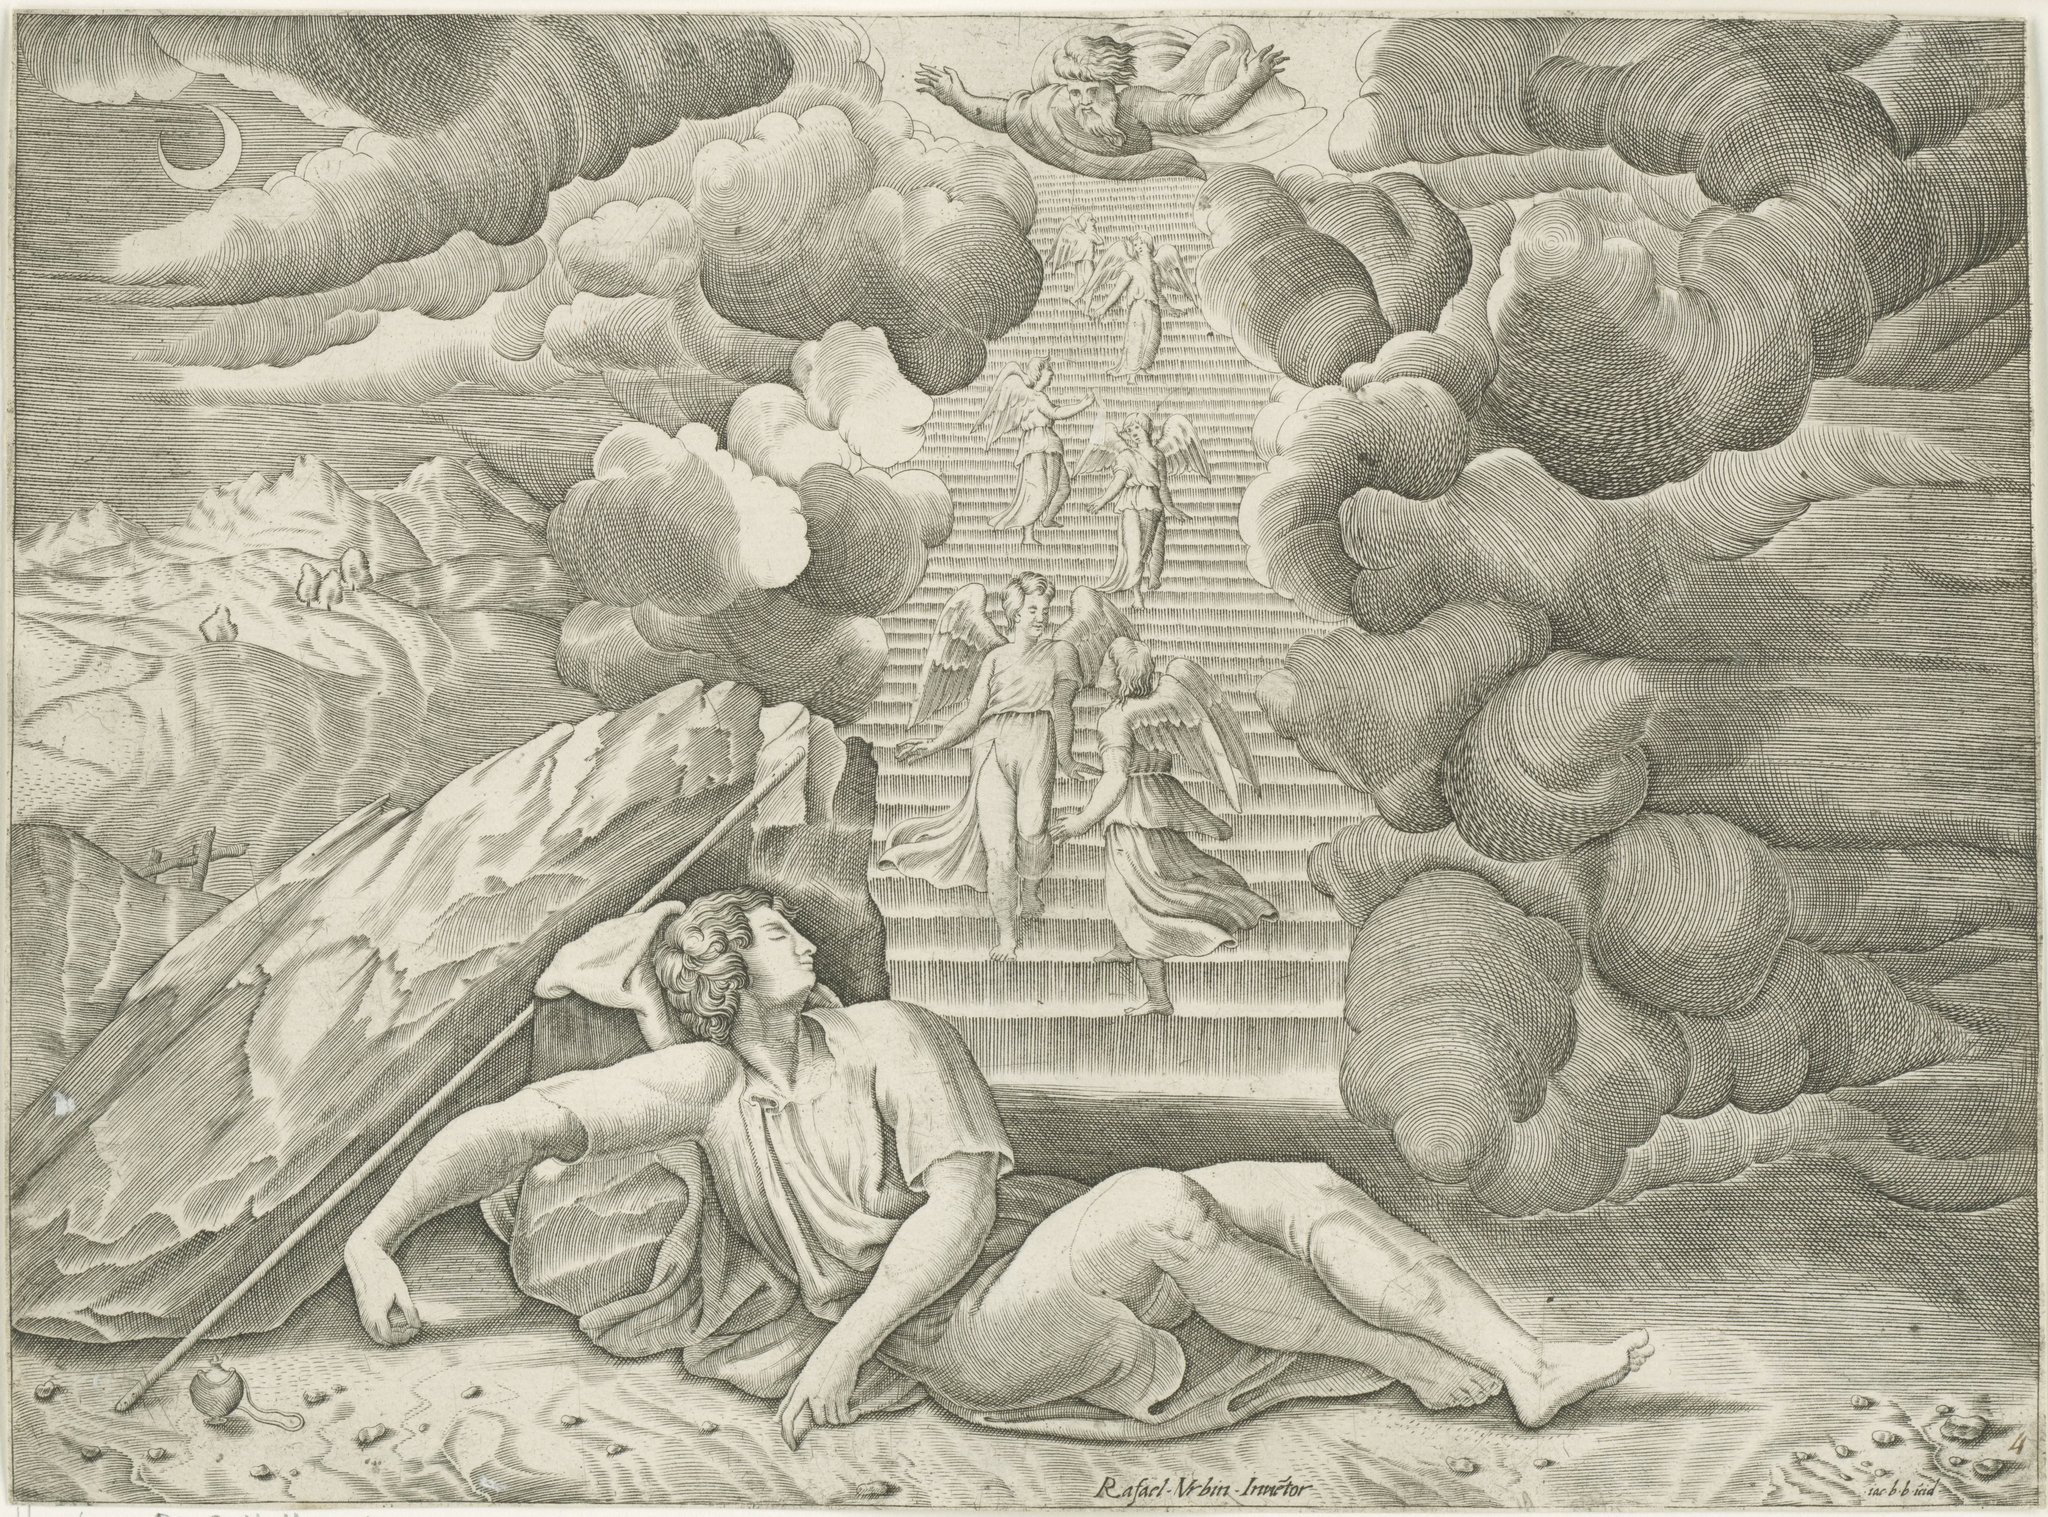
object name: print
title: Jakobs droom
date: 1530-1580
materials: paper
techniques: engraving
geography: rome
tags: the dream of jacob: while sleeping on the ground with a stone for pillow jacob sees a ladder reaching from earth to heaven with angels going up and down; usually with god at the top of the ladder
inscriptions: collector's mark: Lugt 10, collector's mark: Lugt 11, number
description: Een passage uit het Bijbelse verhaal van Jakob is hier uitgebeeld (Gen. 28: 10-22). Tijdens een reis valt Jakob tegen een steen in slaap. Hij droomt over een trap, die tot de hemel reikt en waarop engelen op en af dalen. Bovenaan de trap is God. Hij belooft Jakob en zijn nakomelingen te beschermen.